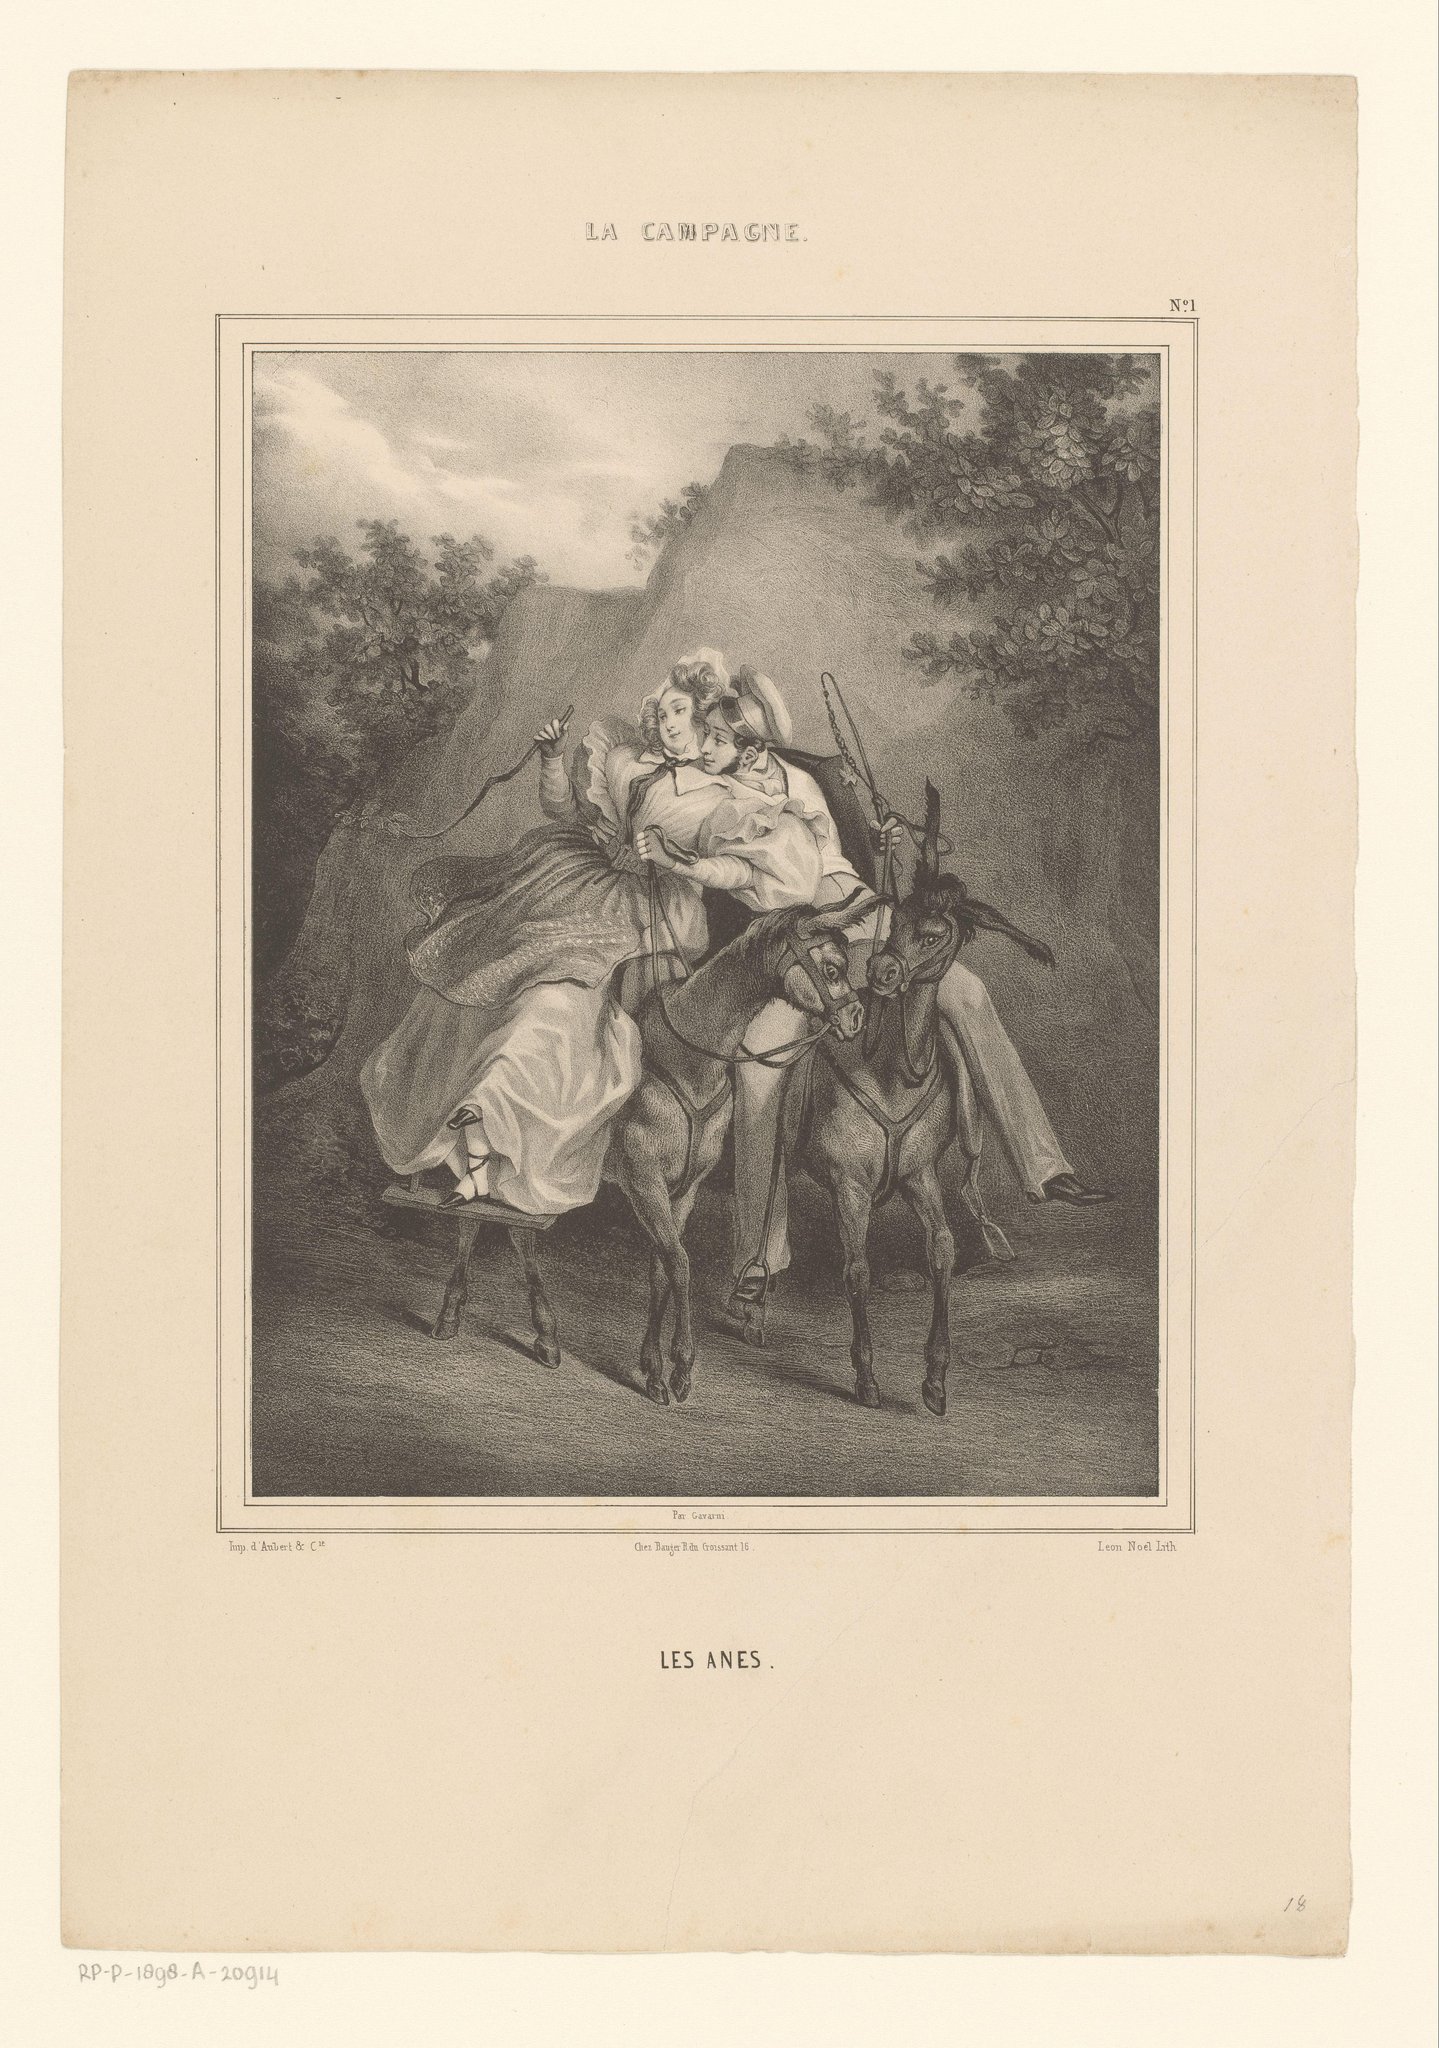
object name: print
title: Les anes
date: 1836-1847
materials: paper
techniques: lithograph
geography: paris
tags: ass, donkey, couple of lovers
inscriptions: collector's mark: Lugt 964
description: "Les ânes". Een heer en dame op ezels gezeten, rijden op een pad, dat langs een heuvel voert. Hij heeft zijn rechterarm om haar middel geslagen en houdt met de linker teugels en zweep. Zij heeft de teugels eveneens links en houdt rechts de zweep. no. 1 van een reeks "La Campagne". Naar een tekening van Gavarni. Gem.: Imp. d' Aubert en Cie chez Bauger R. du Croissant 16. Léon. Noël lith.